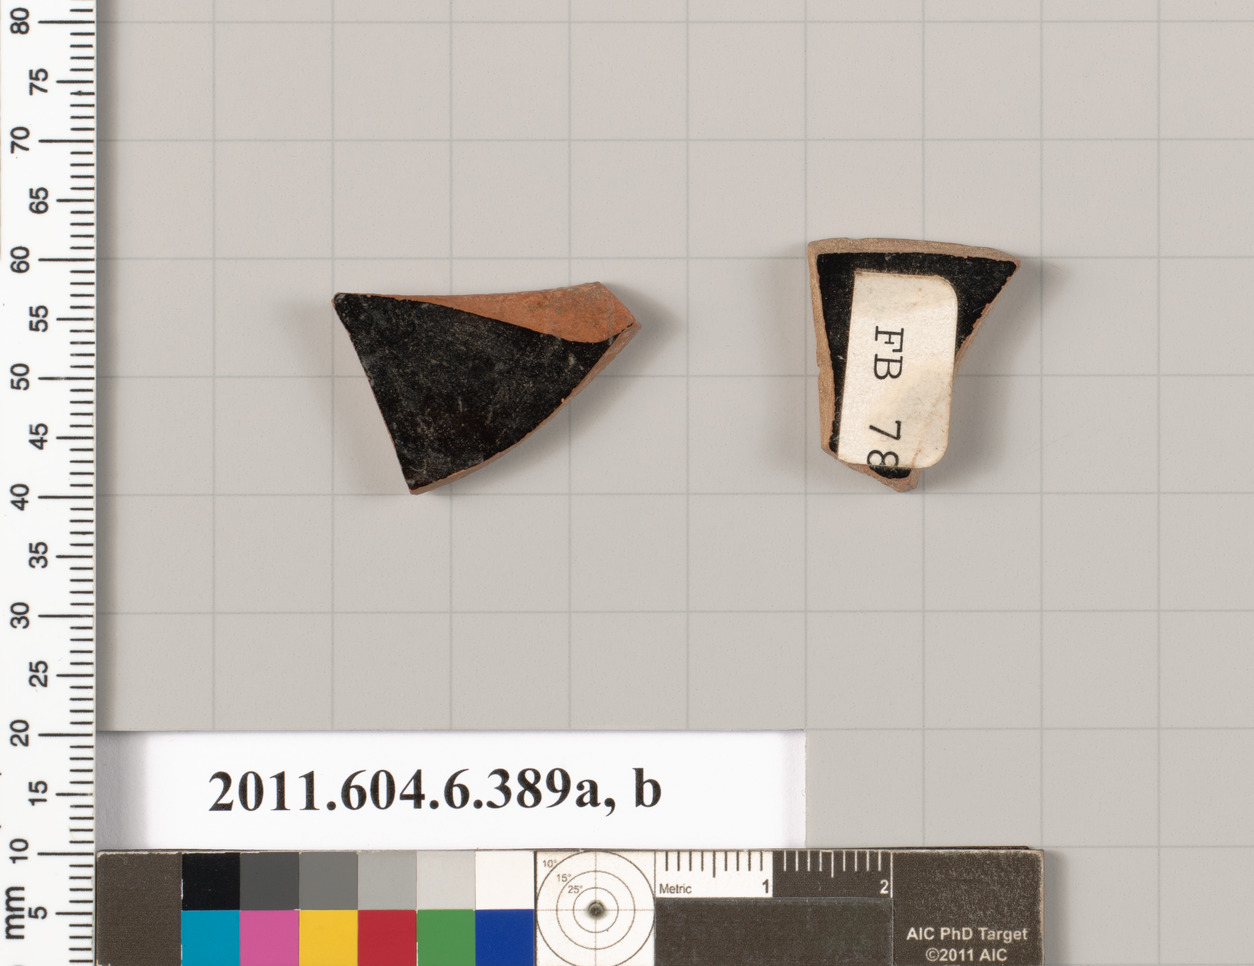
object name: undetermined open shape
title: Terracotta fragments of open shapes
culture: greek, attic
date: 600-401 BCE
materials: terracotta